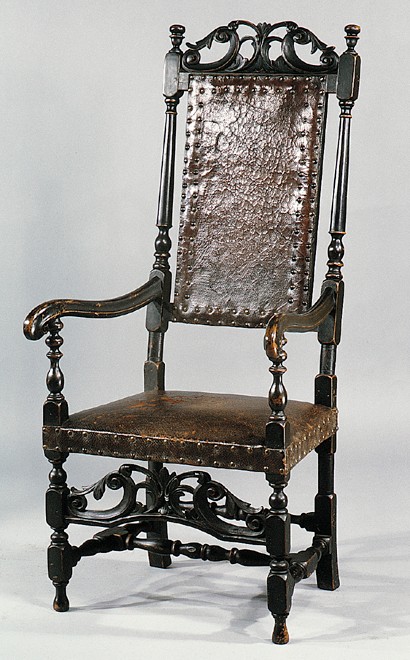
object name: armchair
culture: american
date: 1700-1725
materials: wood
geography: united states